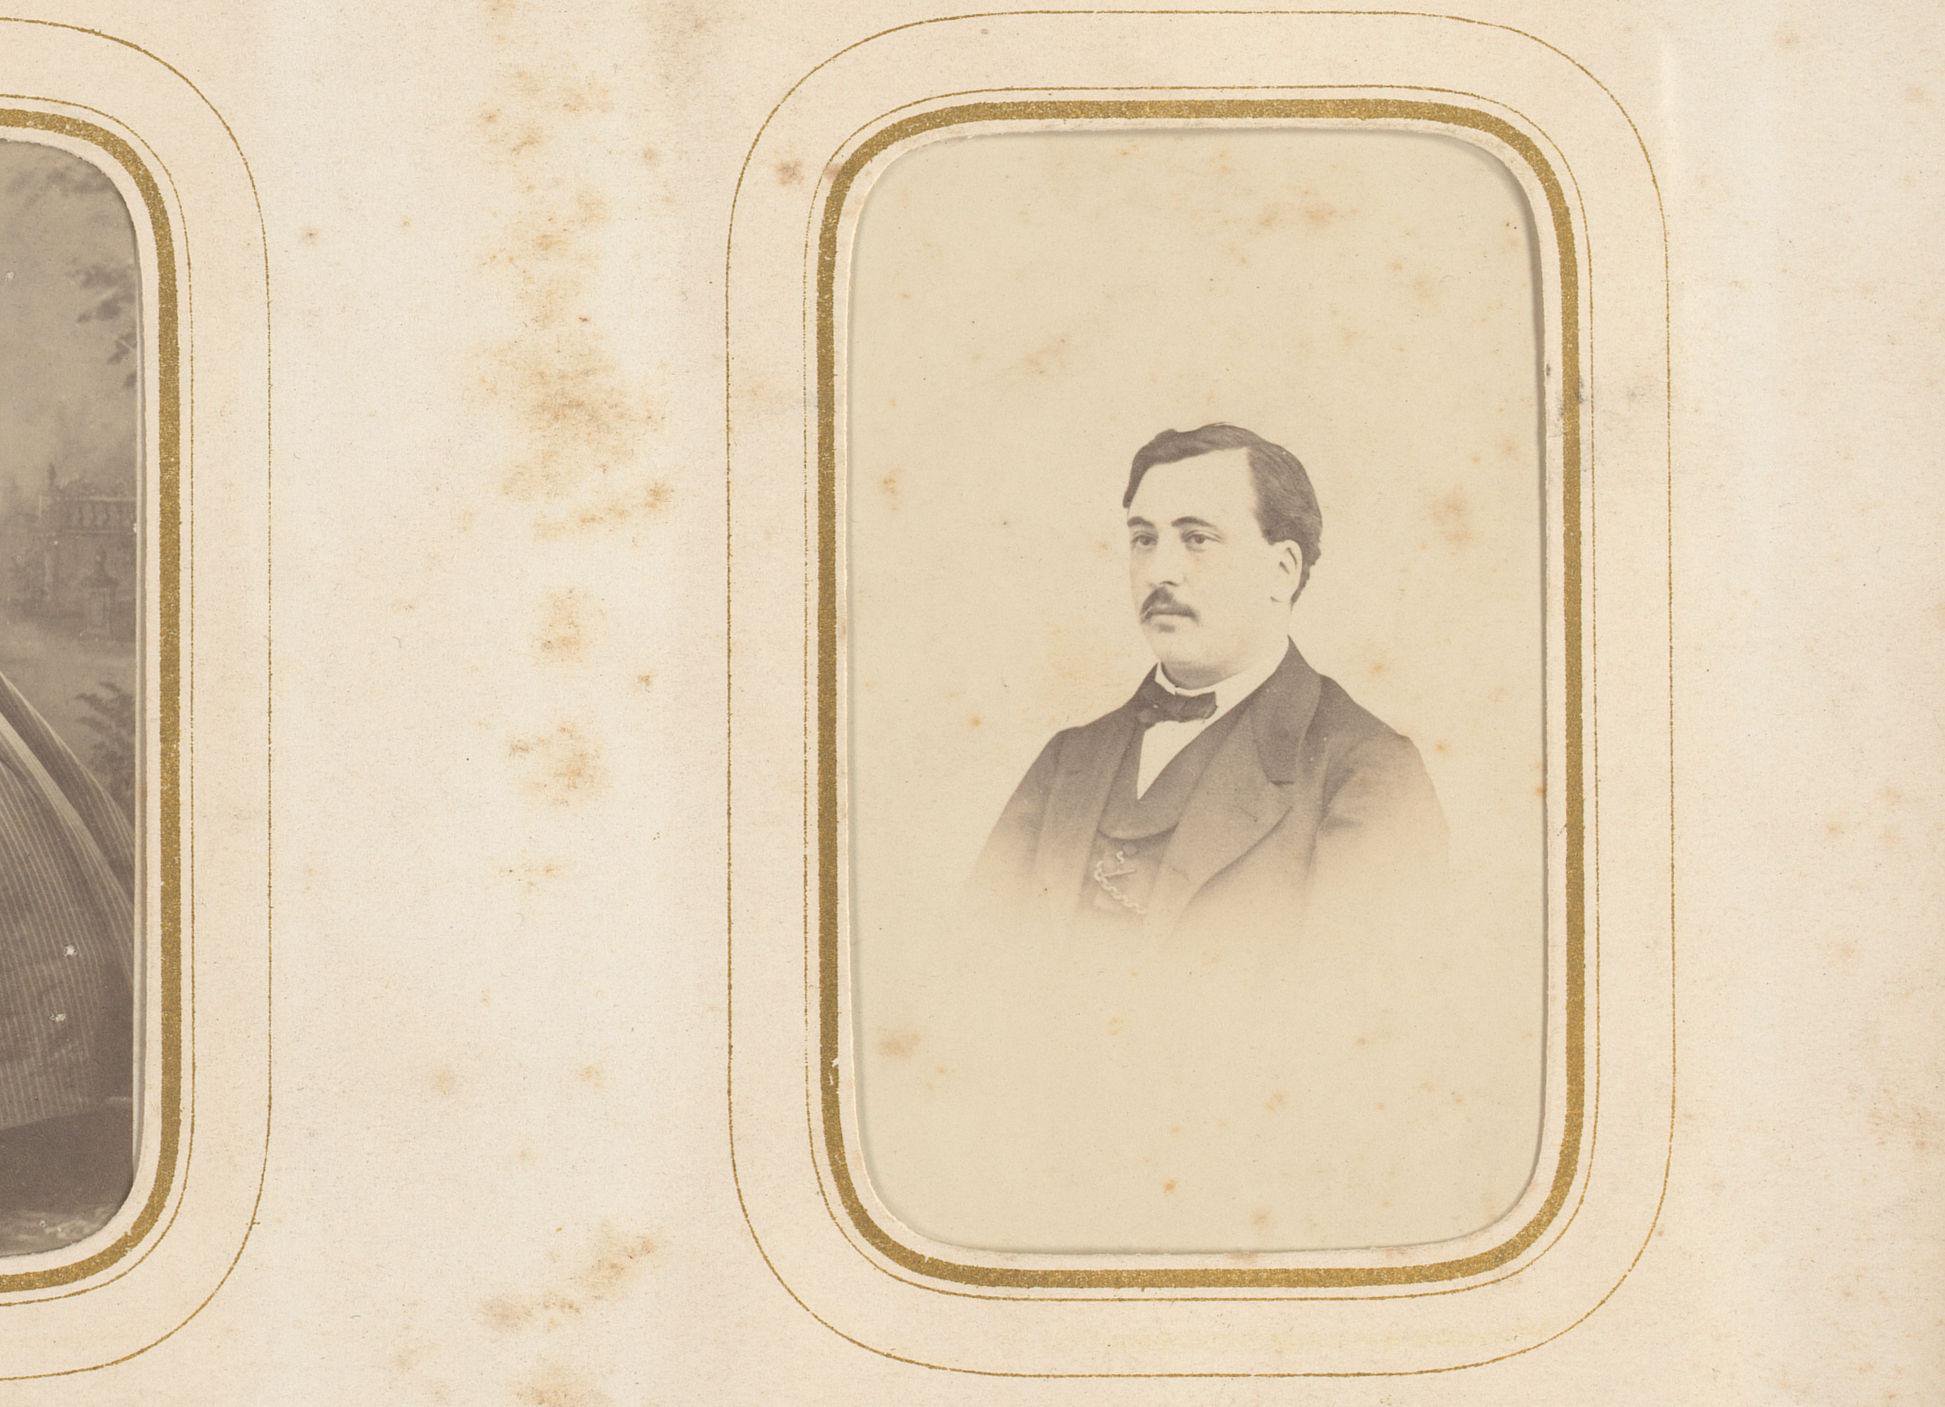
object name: album leaf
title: Portret van een man met snor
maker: benoît bonnet-poméon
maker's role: printer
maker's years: 1827-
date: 1860-1890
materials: cardboard, photographic support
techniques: albumen print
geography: rive-de-gier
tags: moustache, historical persons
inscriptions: inscription: ‘Photographie Artistique/ Bonnet-Poméon/ Rue de Lyon, 15/ Rive-de-Gier/ Loire’